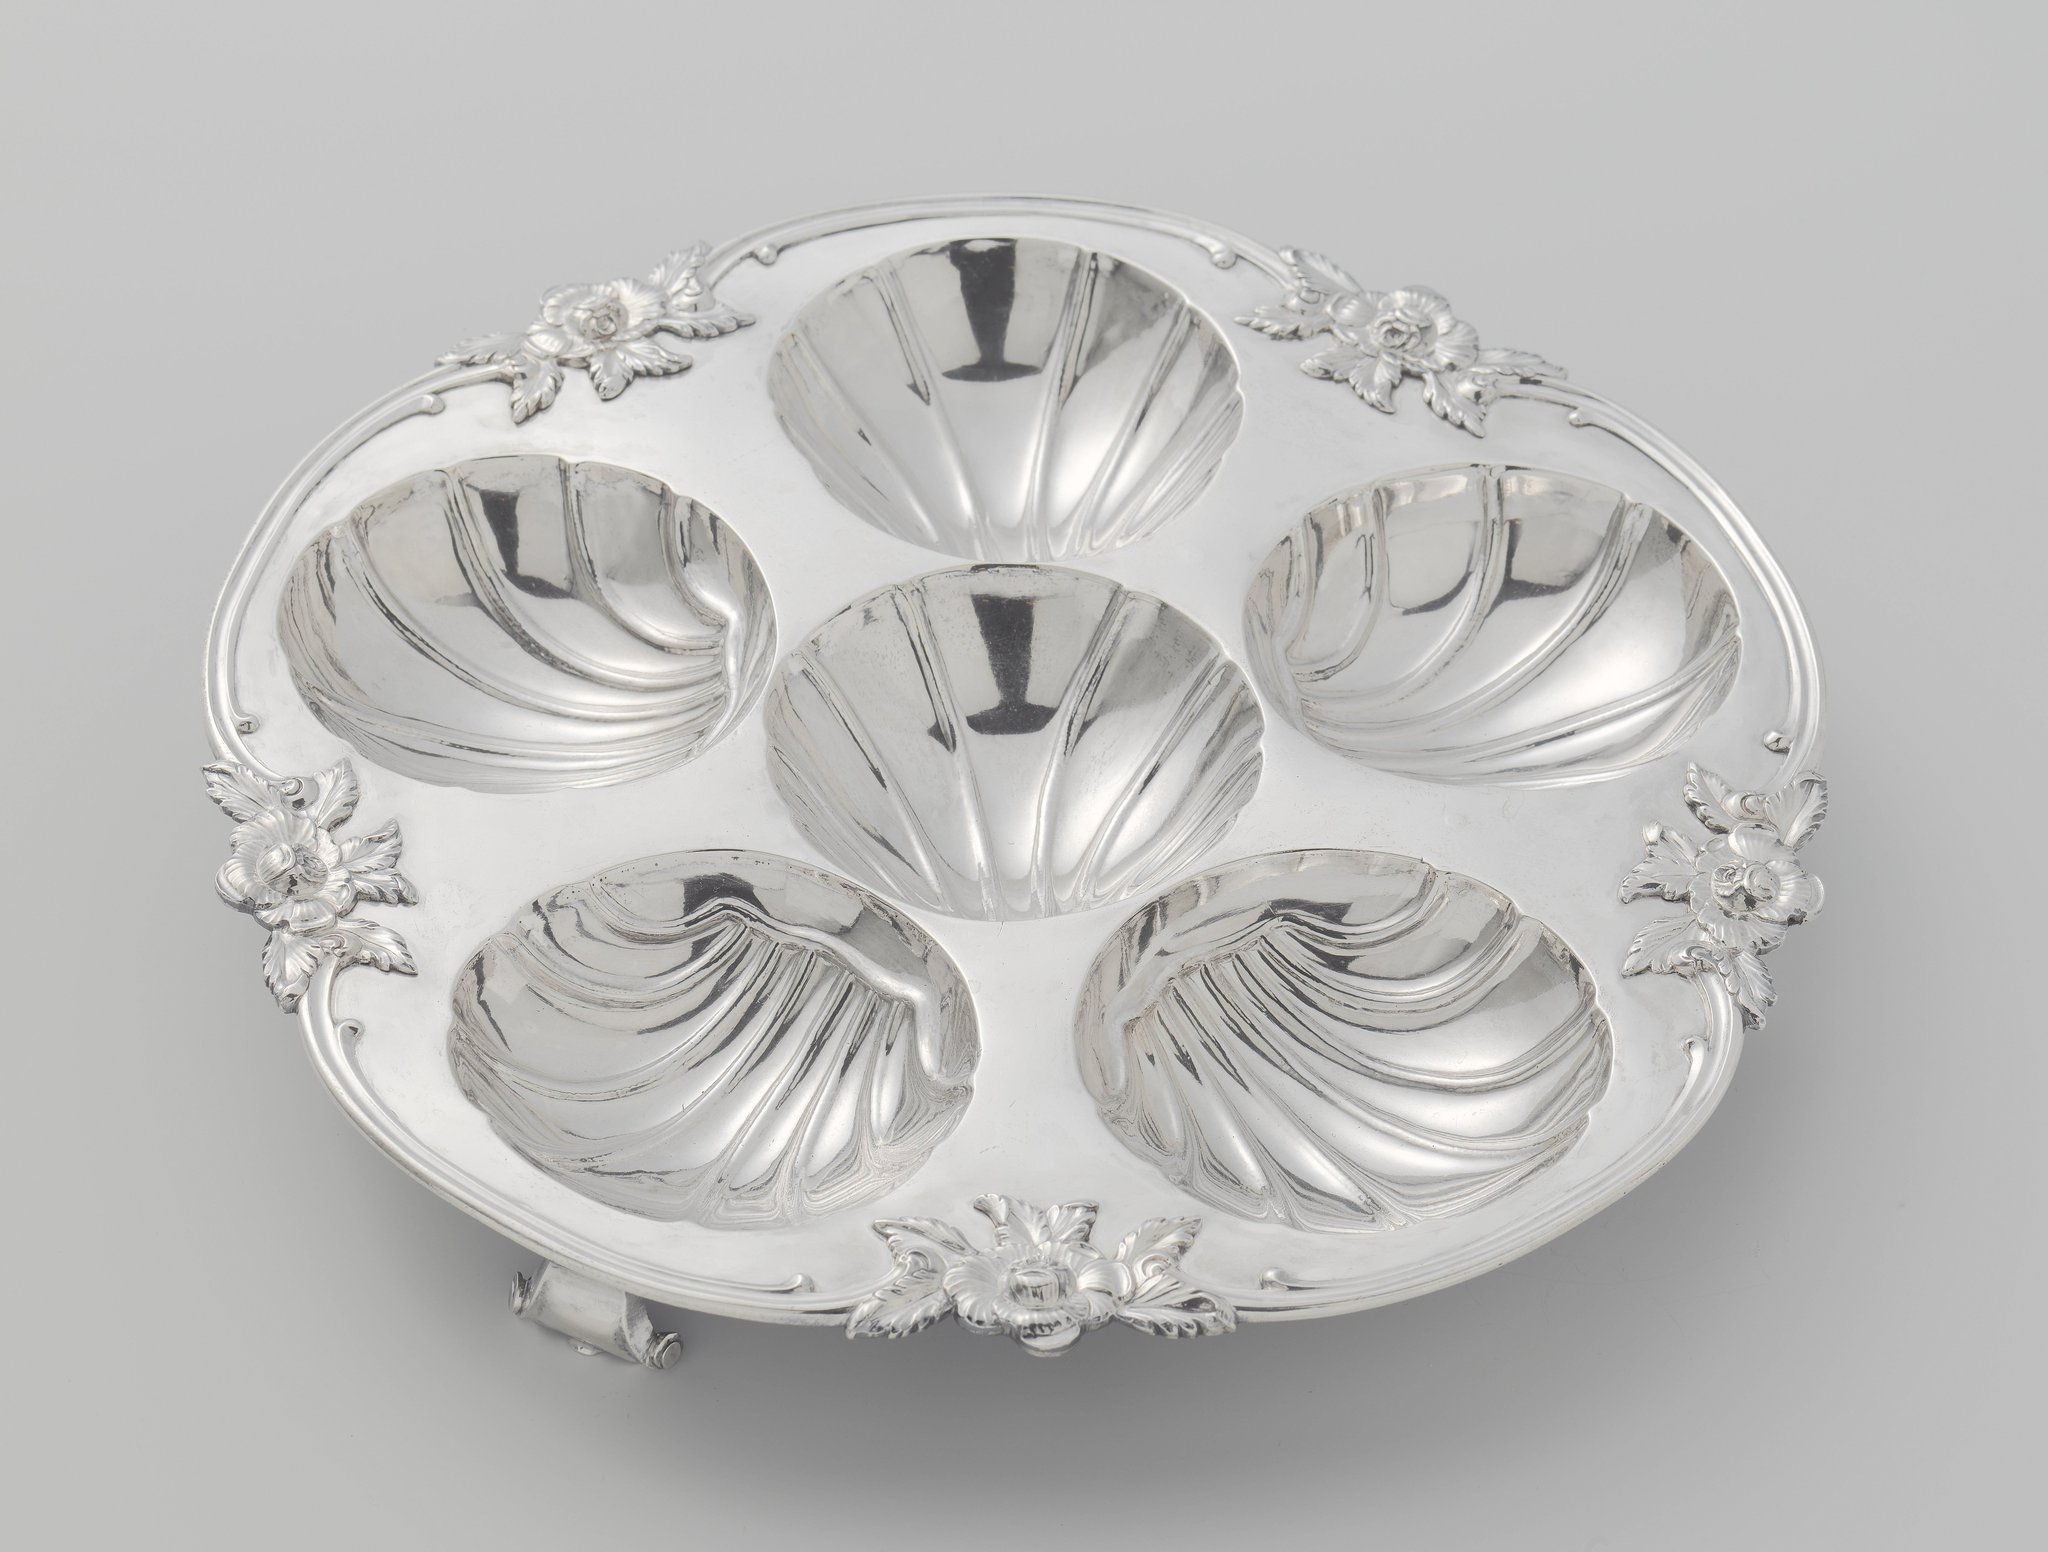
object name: oyster plate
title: Oesterschotel met zes schelpvormige verdiepingen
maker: jacobus rensing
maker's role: silversmith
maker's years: 1723-1772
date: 1770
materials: silver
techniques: casting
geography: amsterdam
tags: scallop, shell ~ ornament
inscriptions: alloy mark, date letter: ‘L’, duty mark, maker's mark, town mark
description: Oyster dish. Silver. Amsterdam, 1770, attributed to Jacobus Rensing.